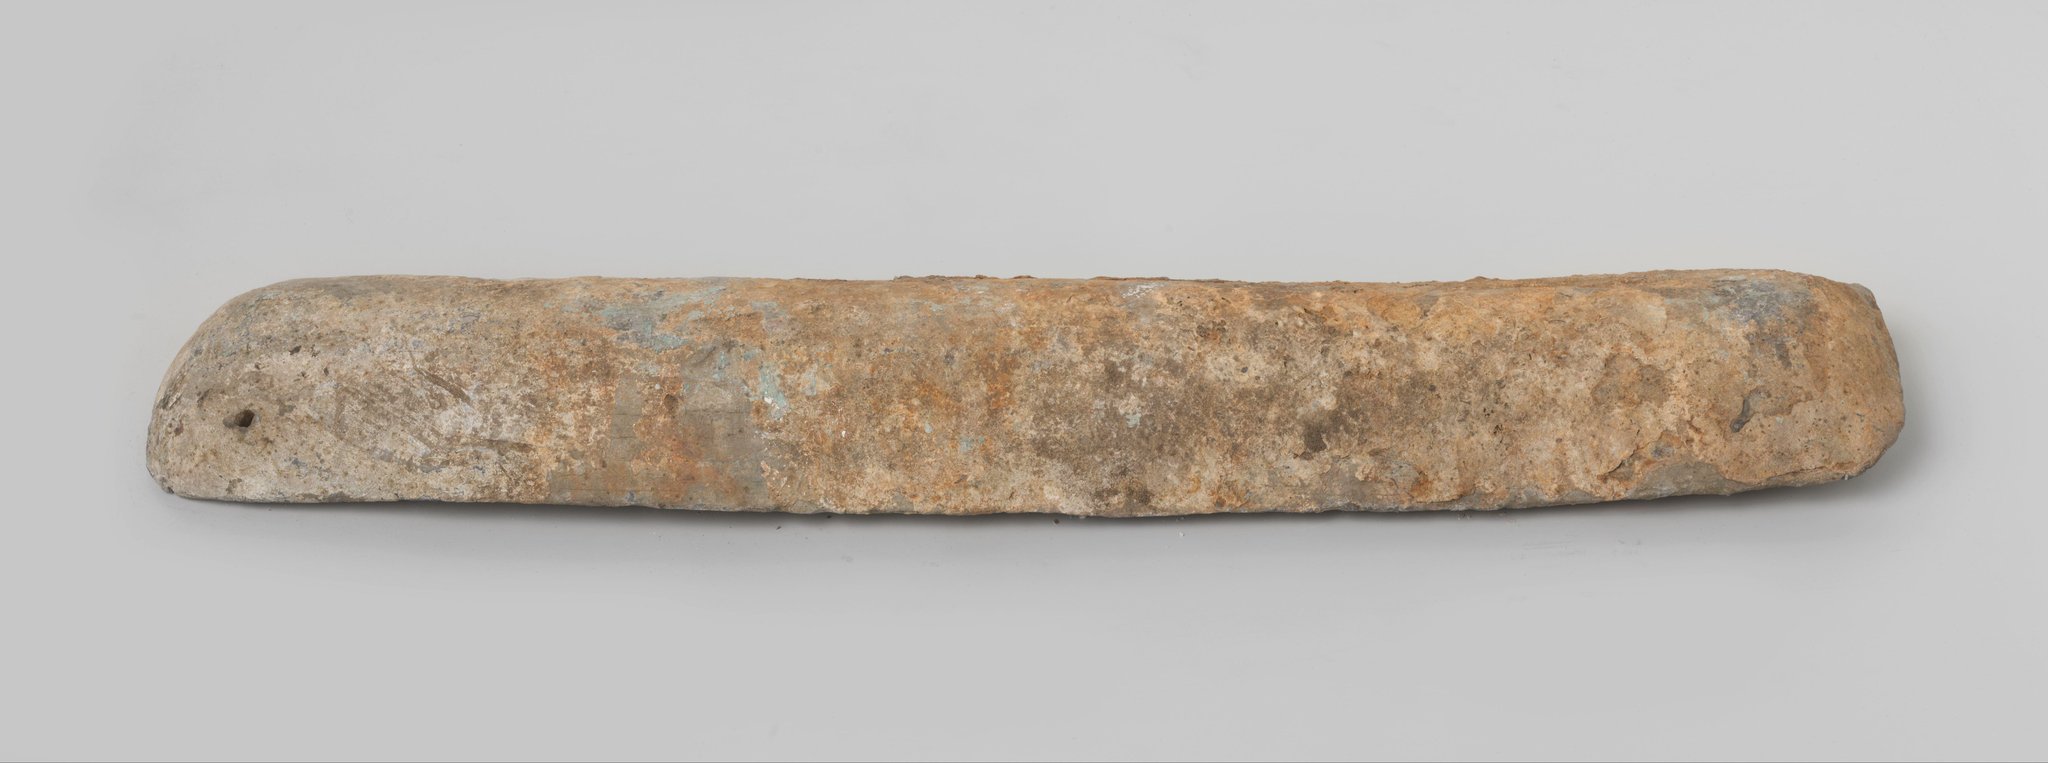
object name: ingot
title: Ballastlood uit het wrak van de Oost-Indiëvaarder Hollandia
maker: Anonymous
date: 1700-1743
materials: lead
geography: netherlands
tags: verenigde oostindische compagnie, hollandia (schip), annet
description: Ingot; (1) corroded, oblong, straight, semicircular ends, flat upper side (87l, 15.8w, 6h), semicircular in section, ends curved, marks legible (L).